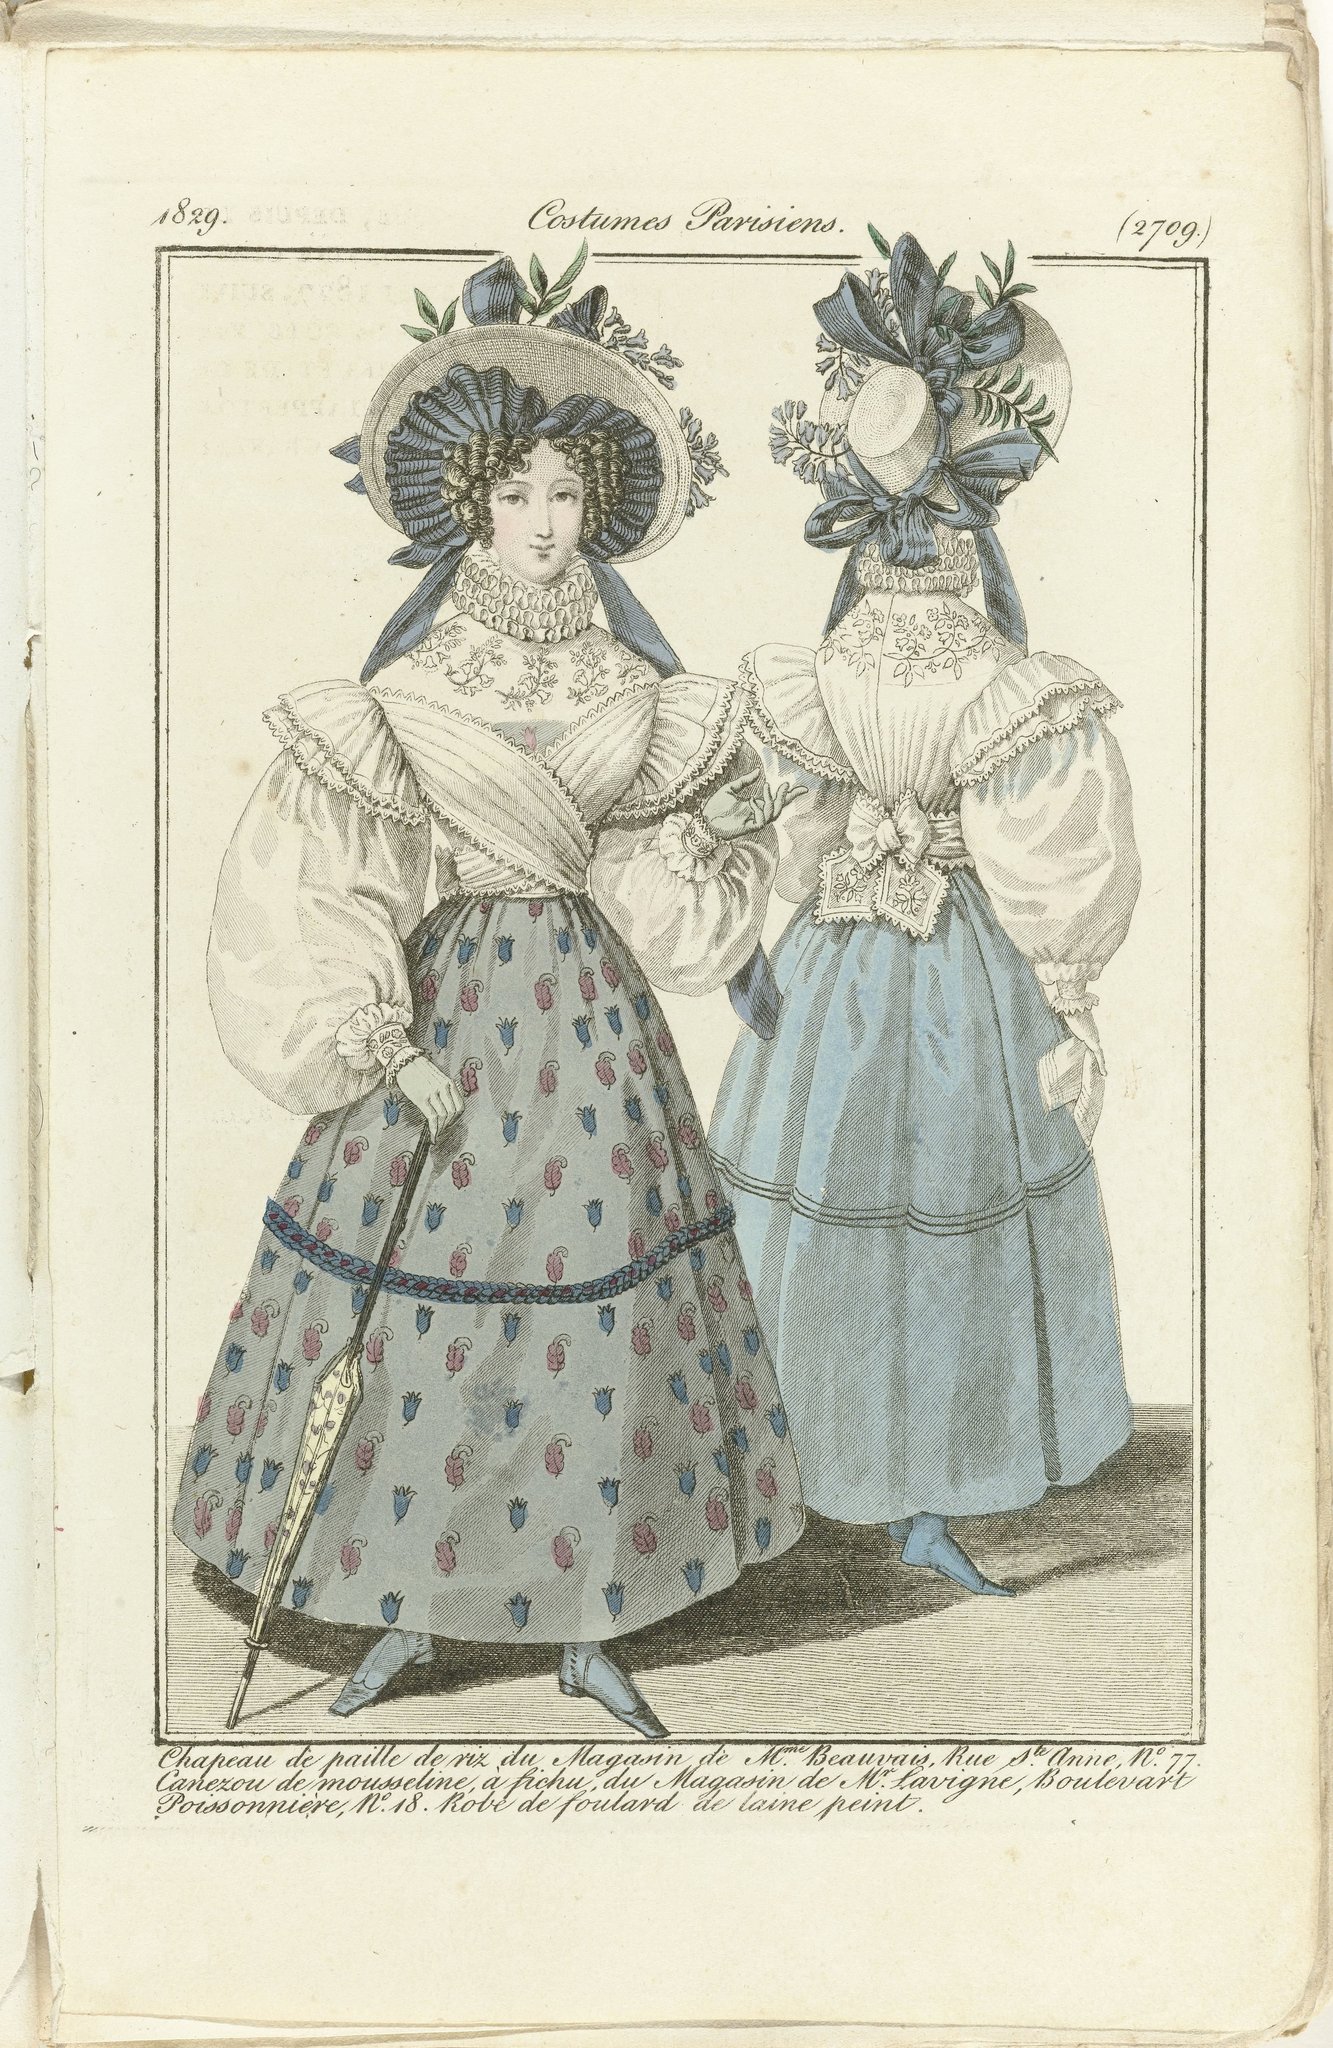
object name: fashion print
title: Journal des Dames et des Modes 1829, Costumes Parisiens (2709)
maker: Anonymous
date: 1829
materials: paper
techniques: etching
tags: fashion plates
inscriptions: date